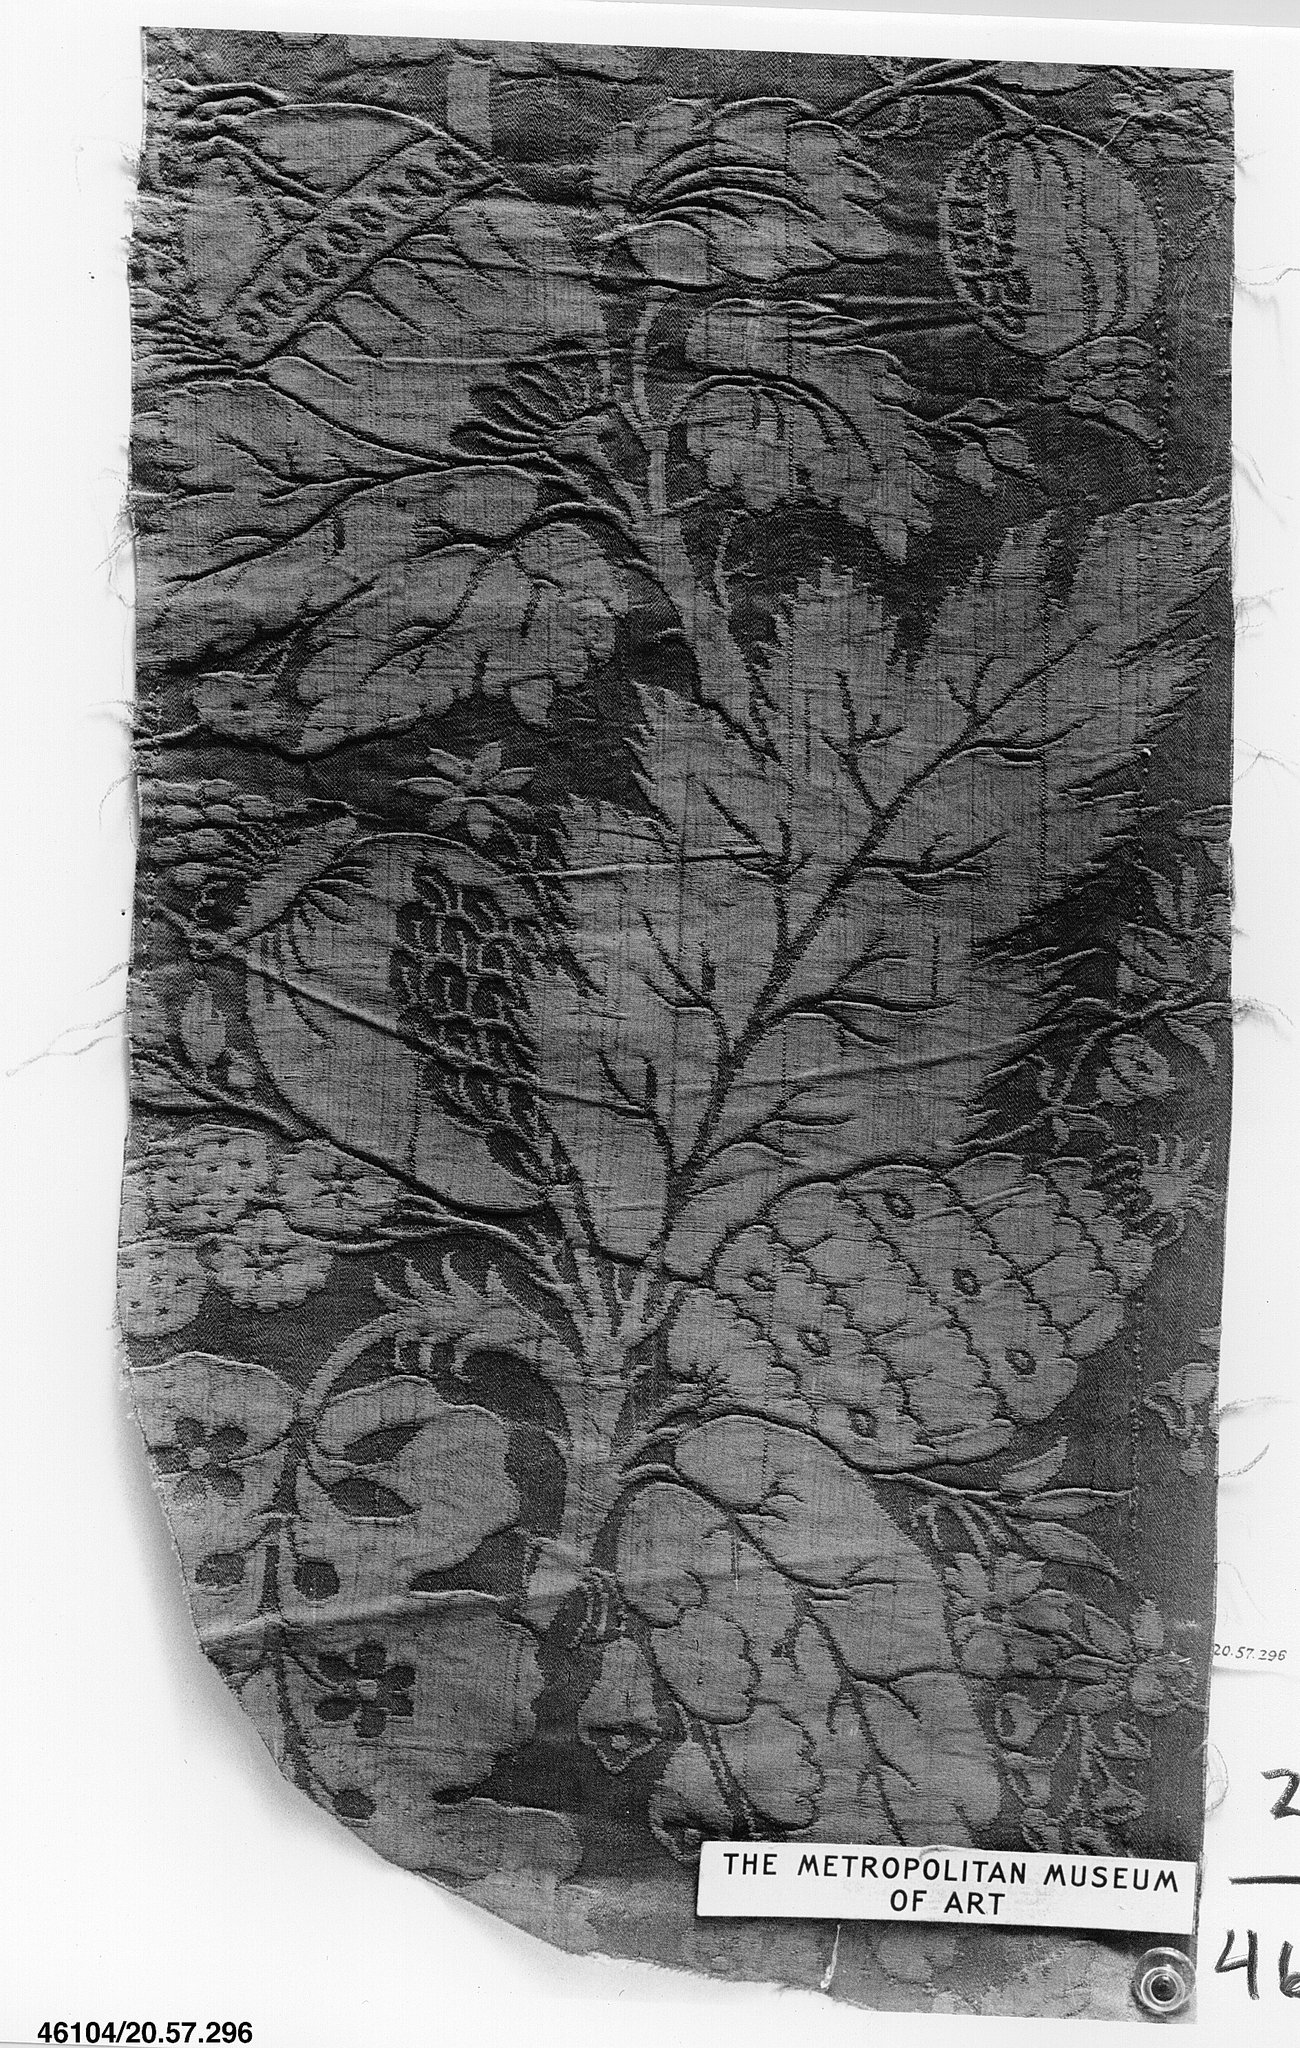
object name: piece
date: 1730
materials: silk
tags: flowers,leaves